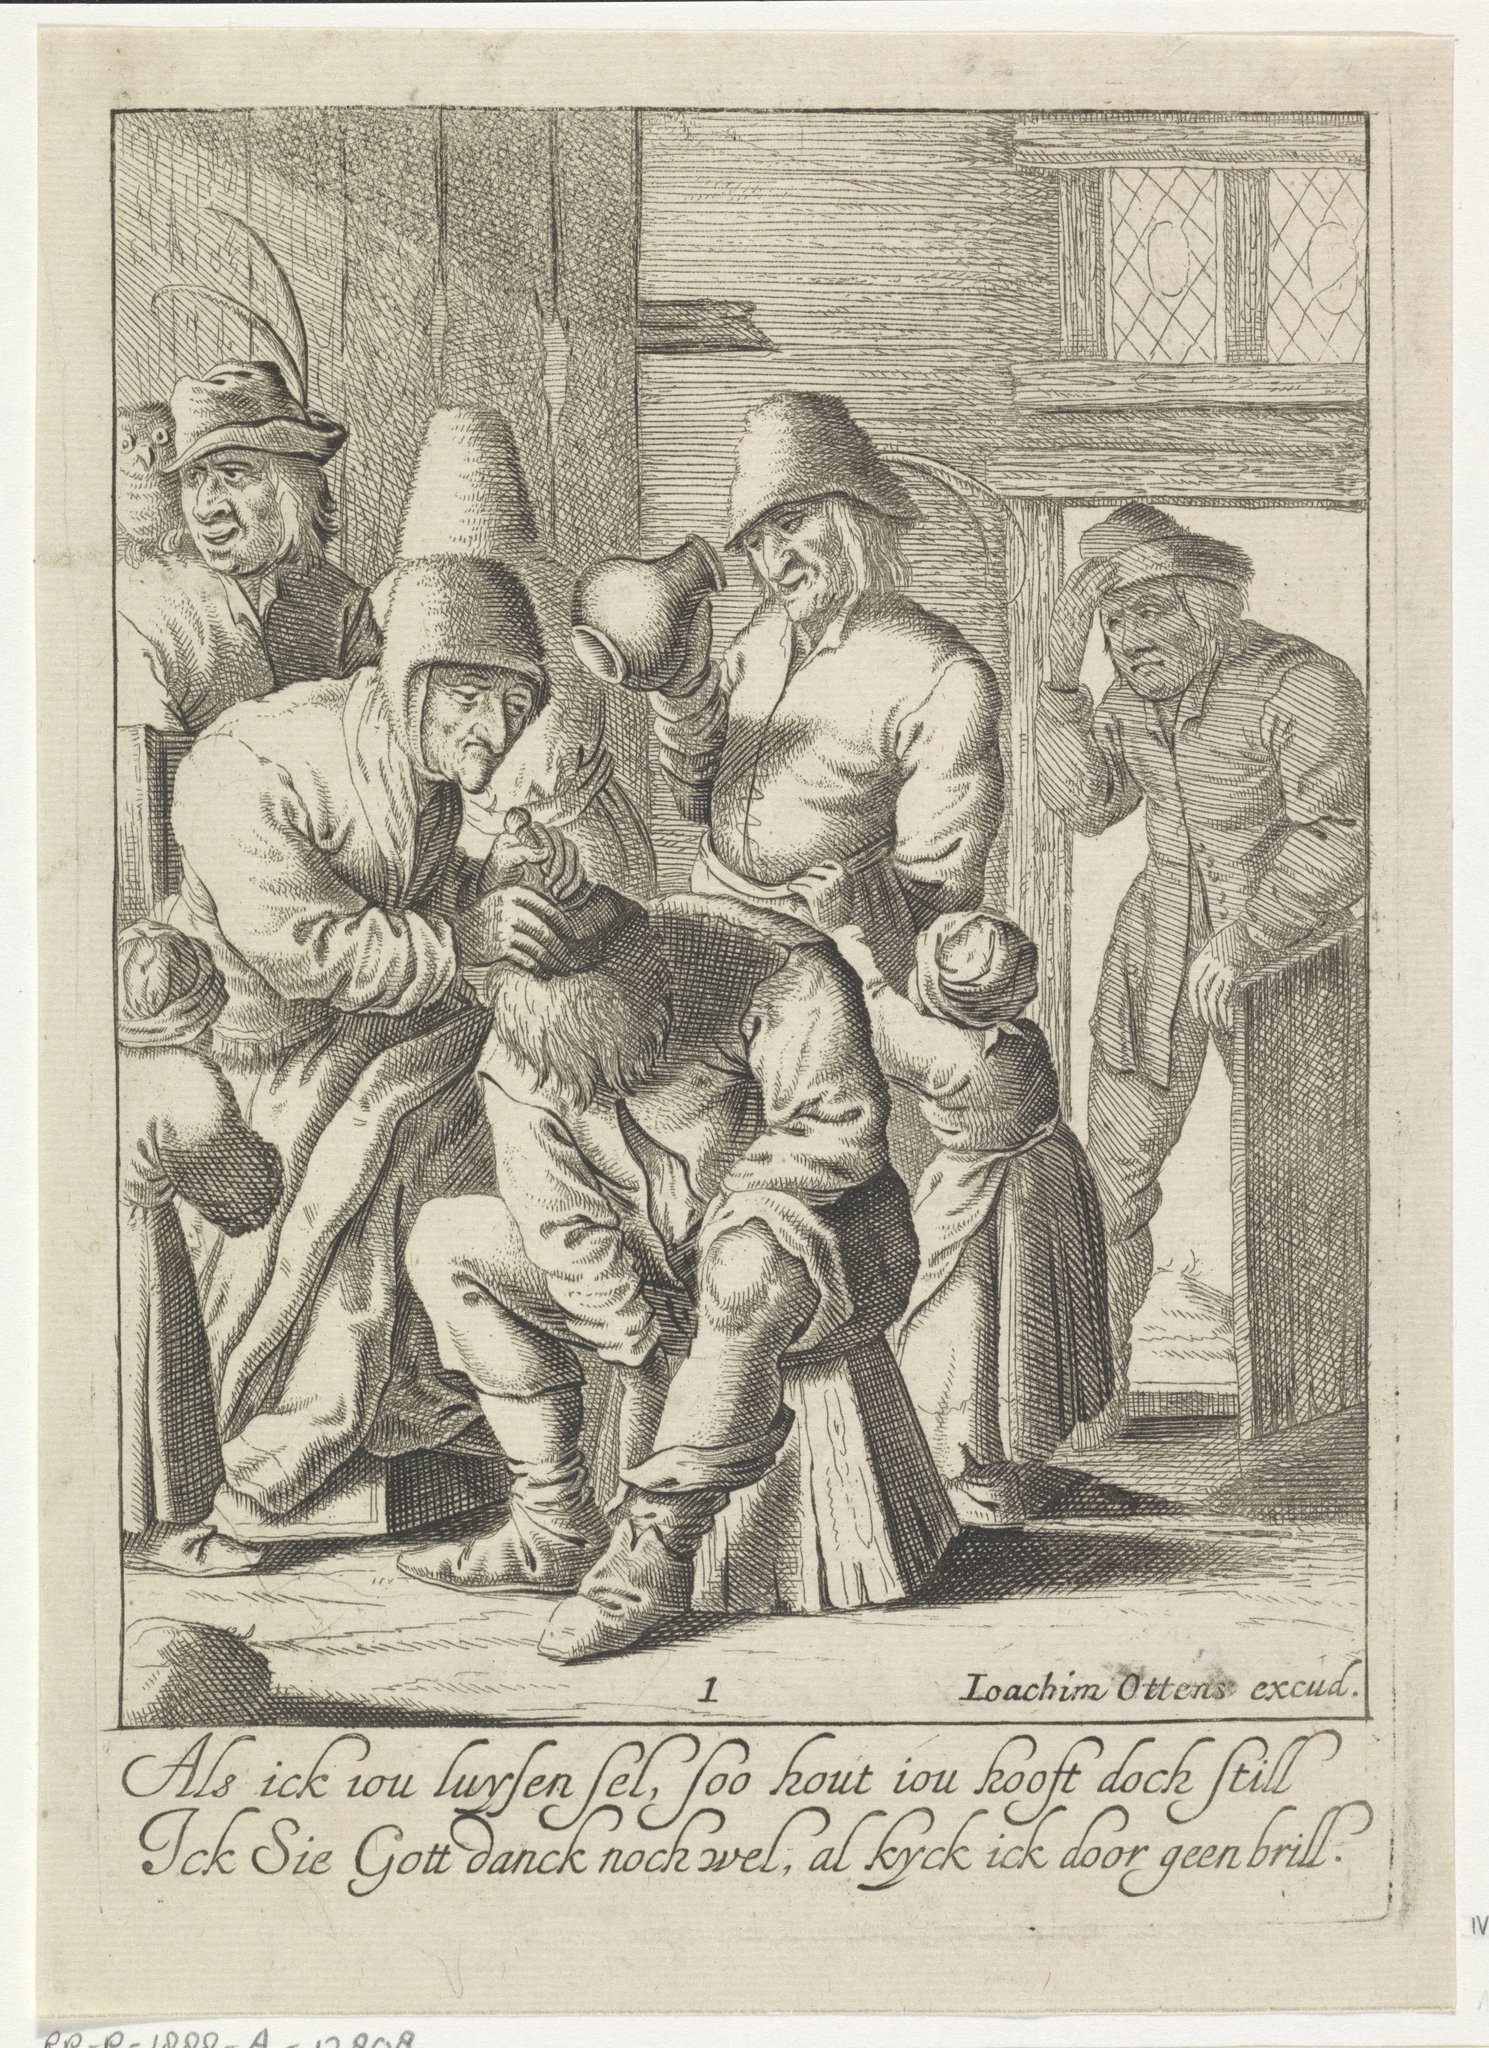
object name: print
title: Gezicht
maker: joachim ottens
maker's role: print maker, publisher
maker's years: 1663-1719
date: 1689-1720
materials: paper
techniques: etching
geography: amsterdam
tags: sight, looking (one of the five senses), old woman, owls, 'motherly care', delousing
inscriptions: collector's mark: Lugt 2228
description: Een oude vrouw onderzoekt de haren van een man op luizen. Onder de voorstelling een tweeregelig vers in het Nederlands. De prent maakt deel uit van een serie van vijf prenten met de vijf zintuigen.